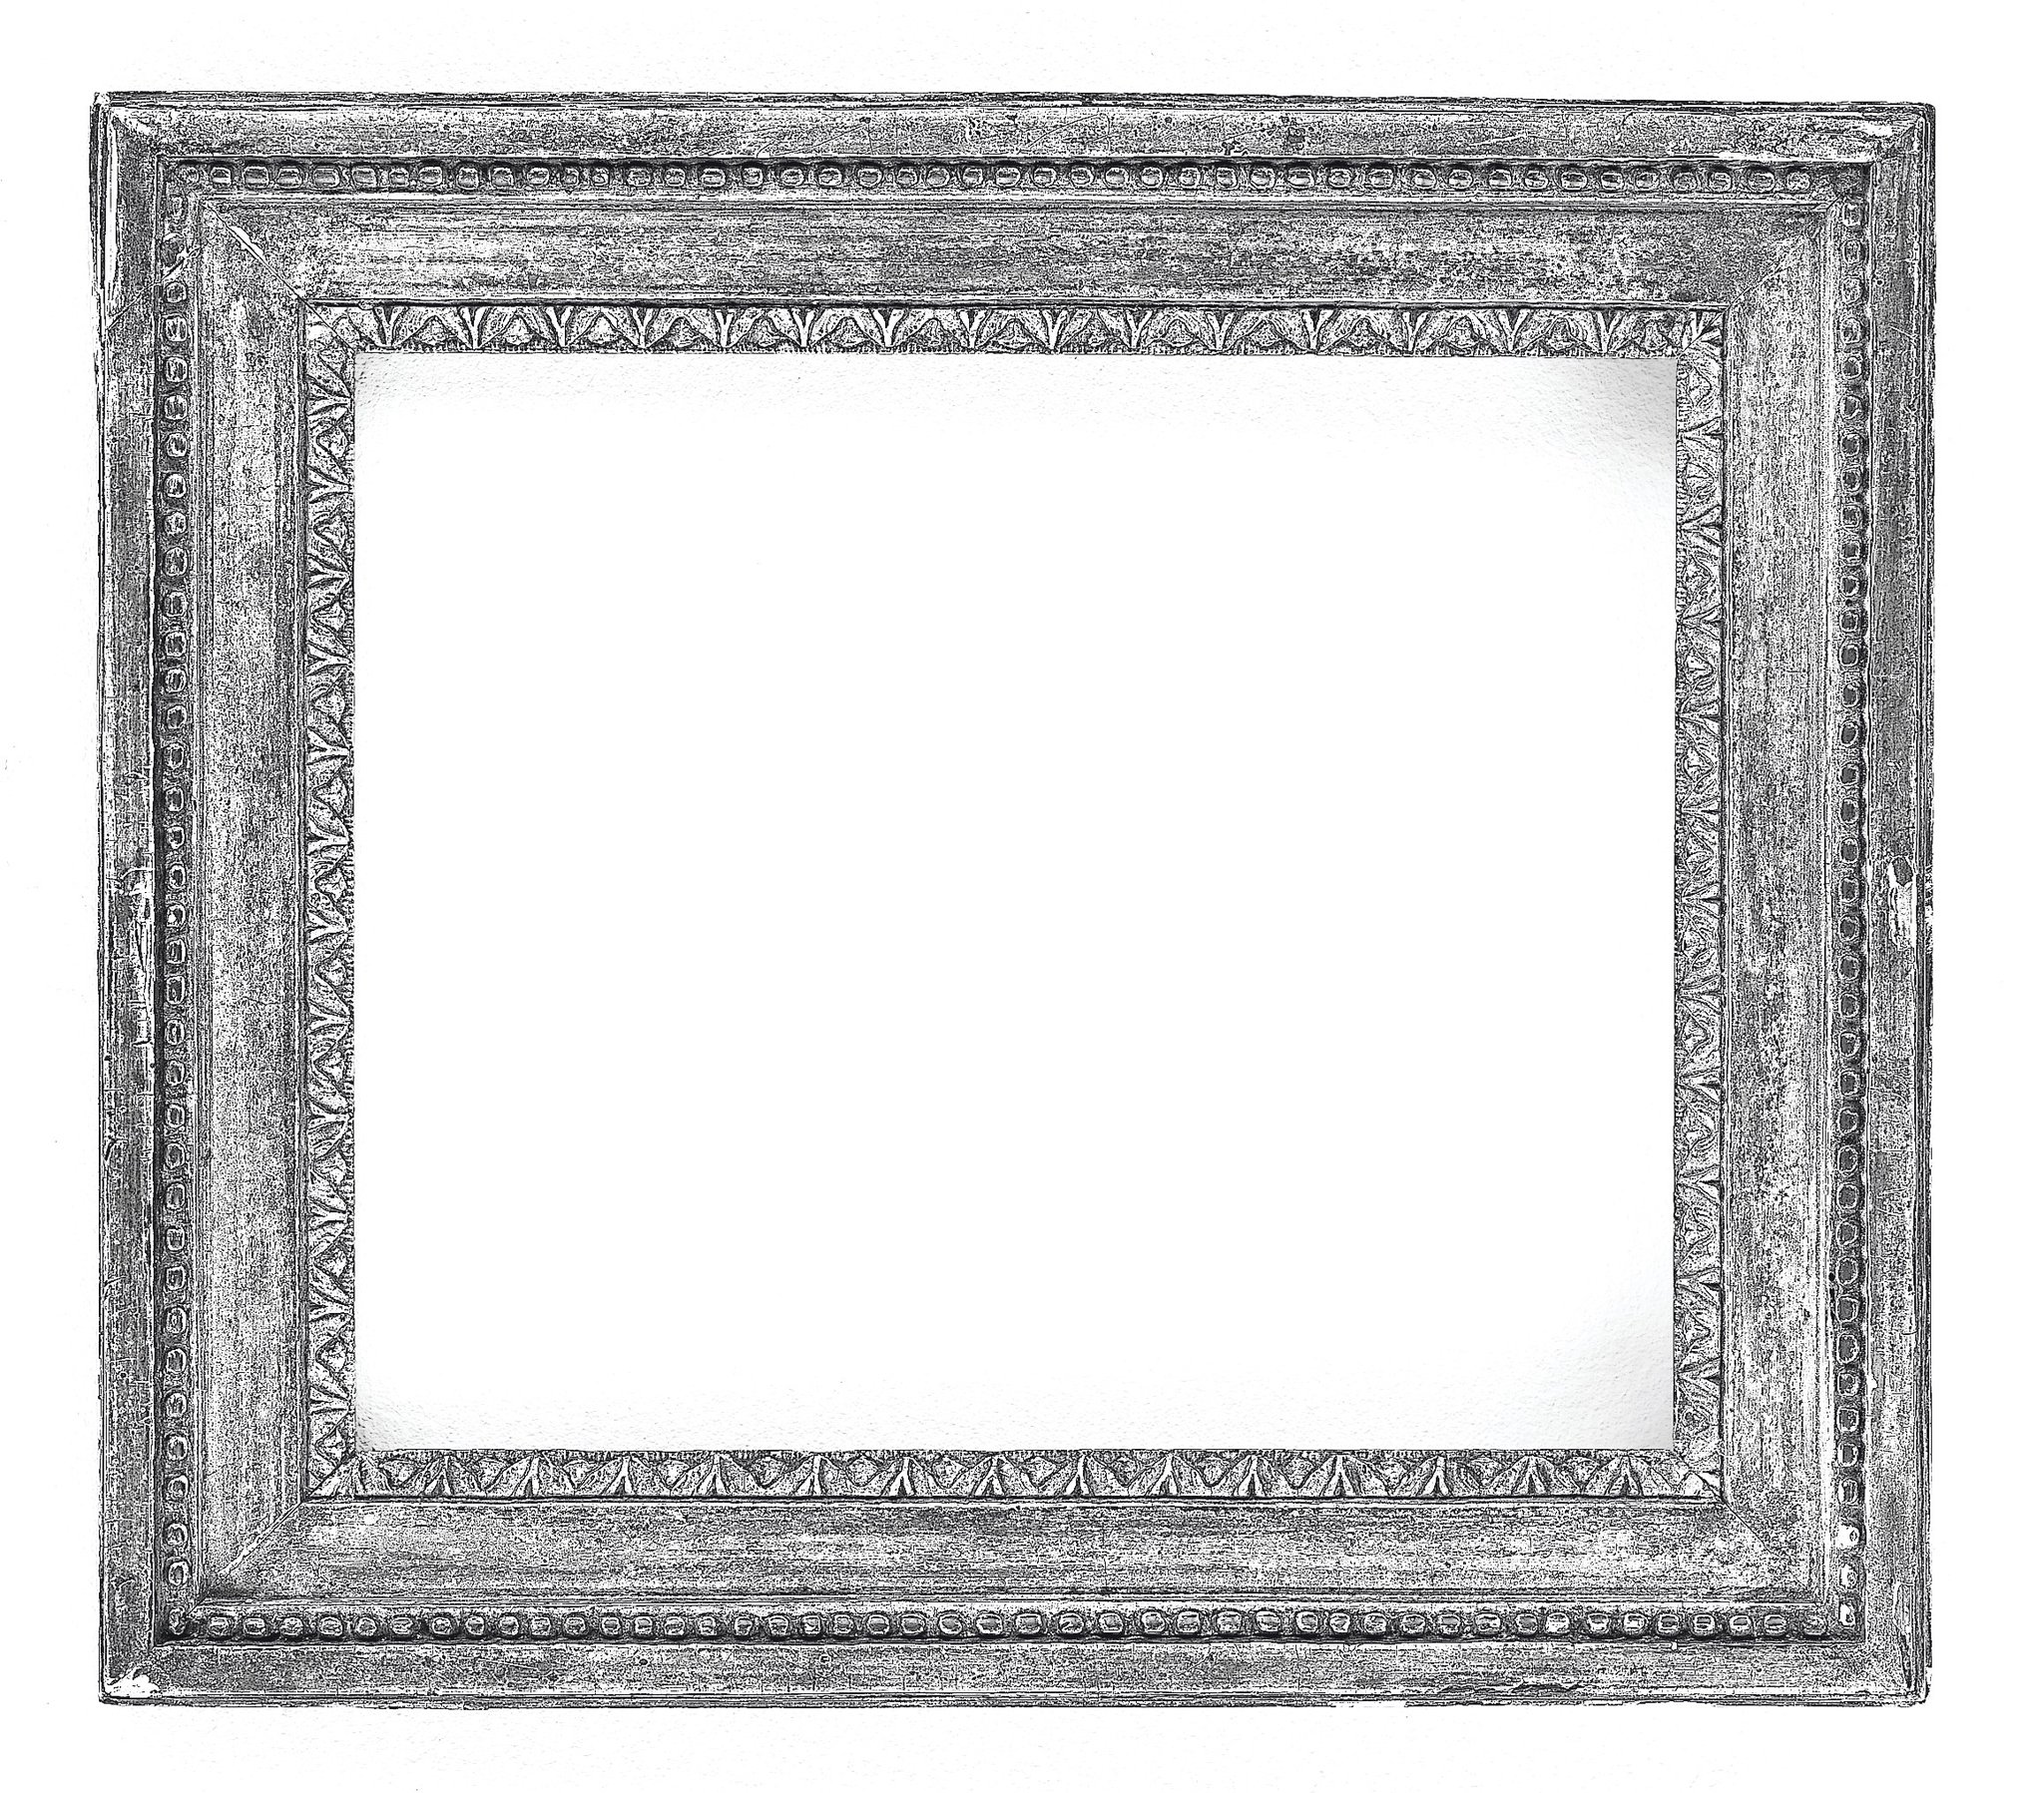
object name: frame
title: Cassetta frame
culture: french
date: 1780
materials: wood